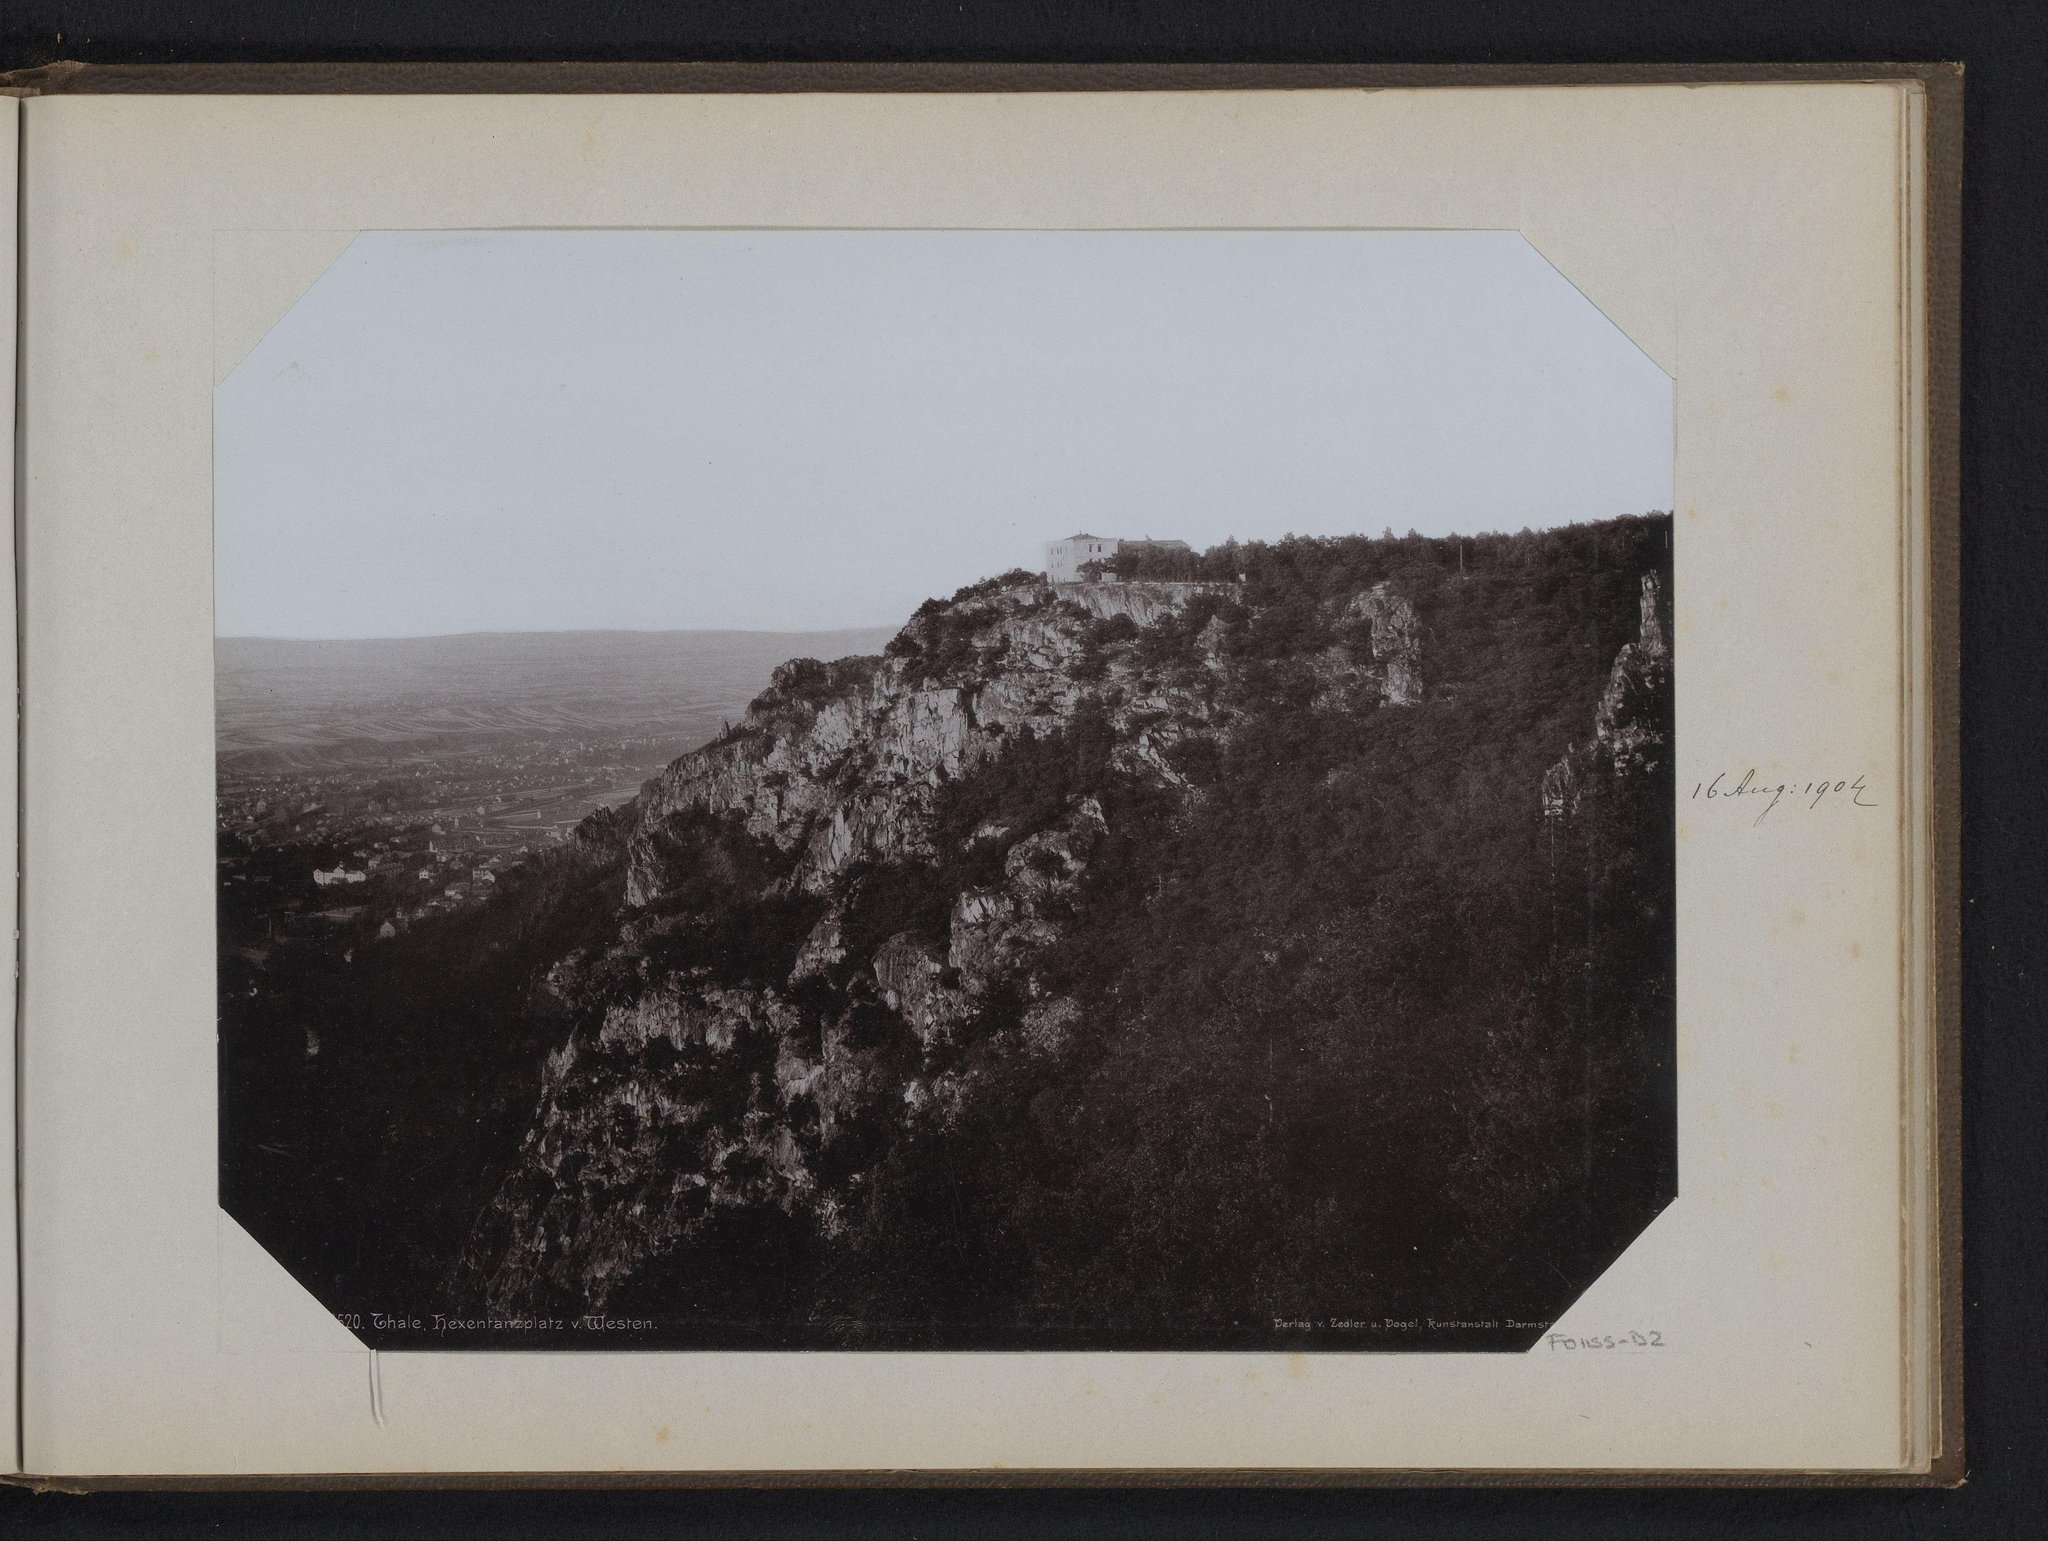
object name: photomechanical print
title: Gezicht op de Hexentanzplats te Thale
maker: Anonymous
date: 1898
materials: paper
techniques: photograph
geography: darmstadt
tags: mountain-range, snow peaks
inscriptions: annotation: ‘16 Aug: 1904’, inscription: ‘3520. Thale, Hexentanzplatz v. Westen/ Verlag v. Zedler u. Vogel, Kunstanstalt Darmstadt 1898’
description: Deze prent maakt deel uit van een album.